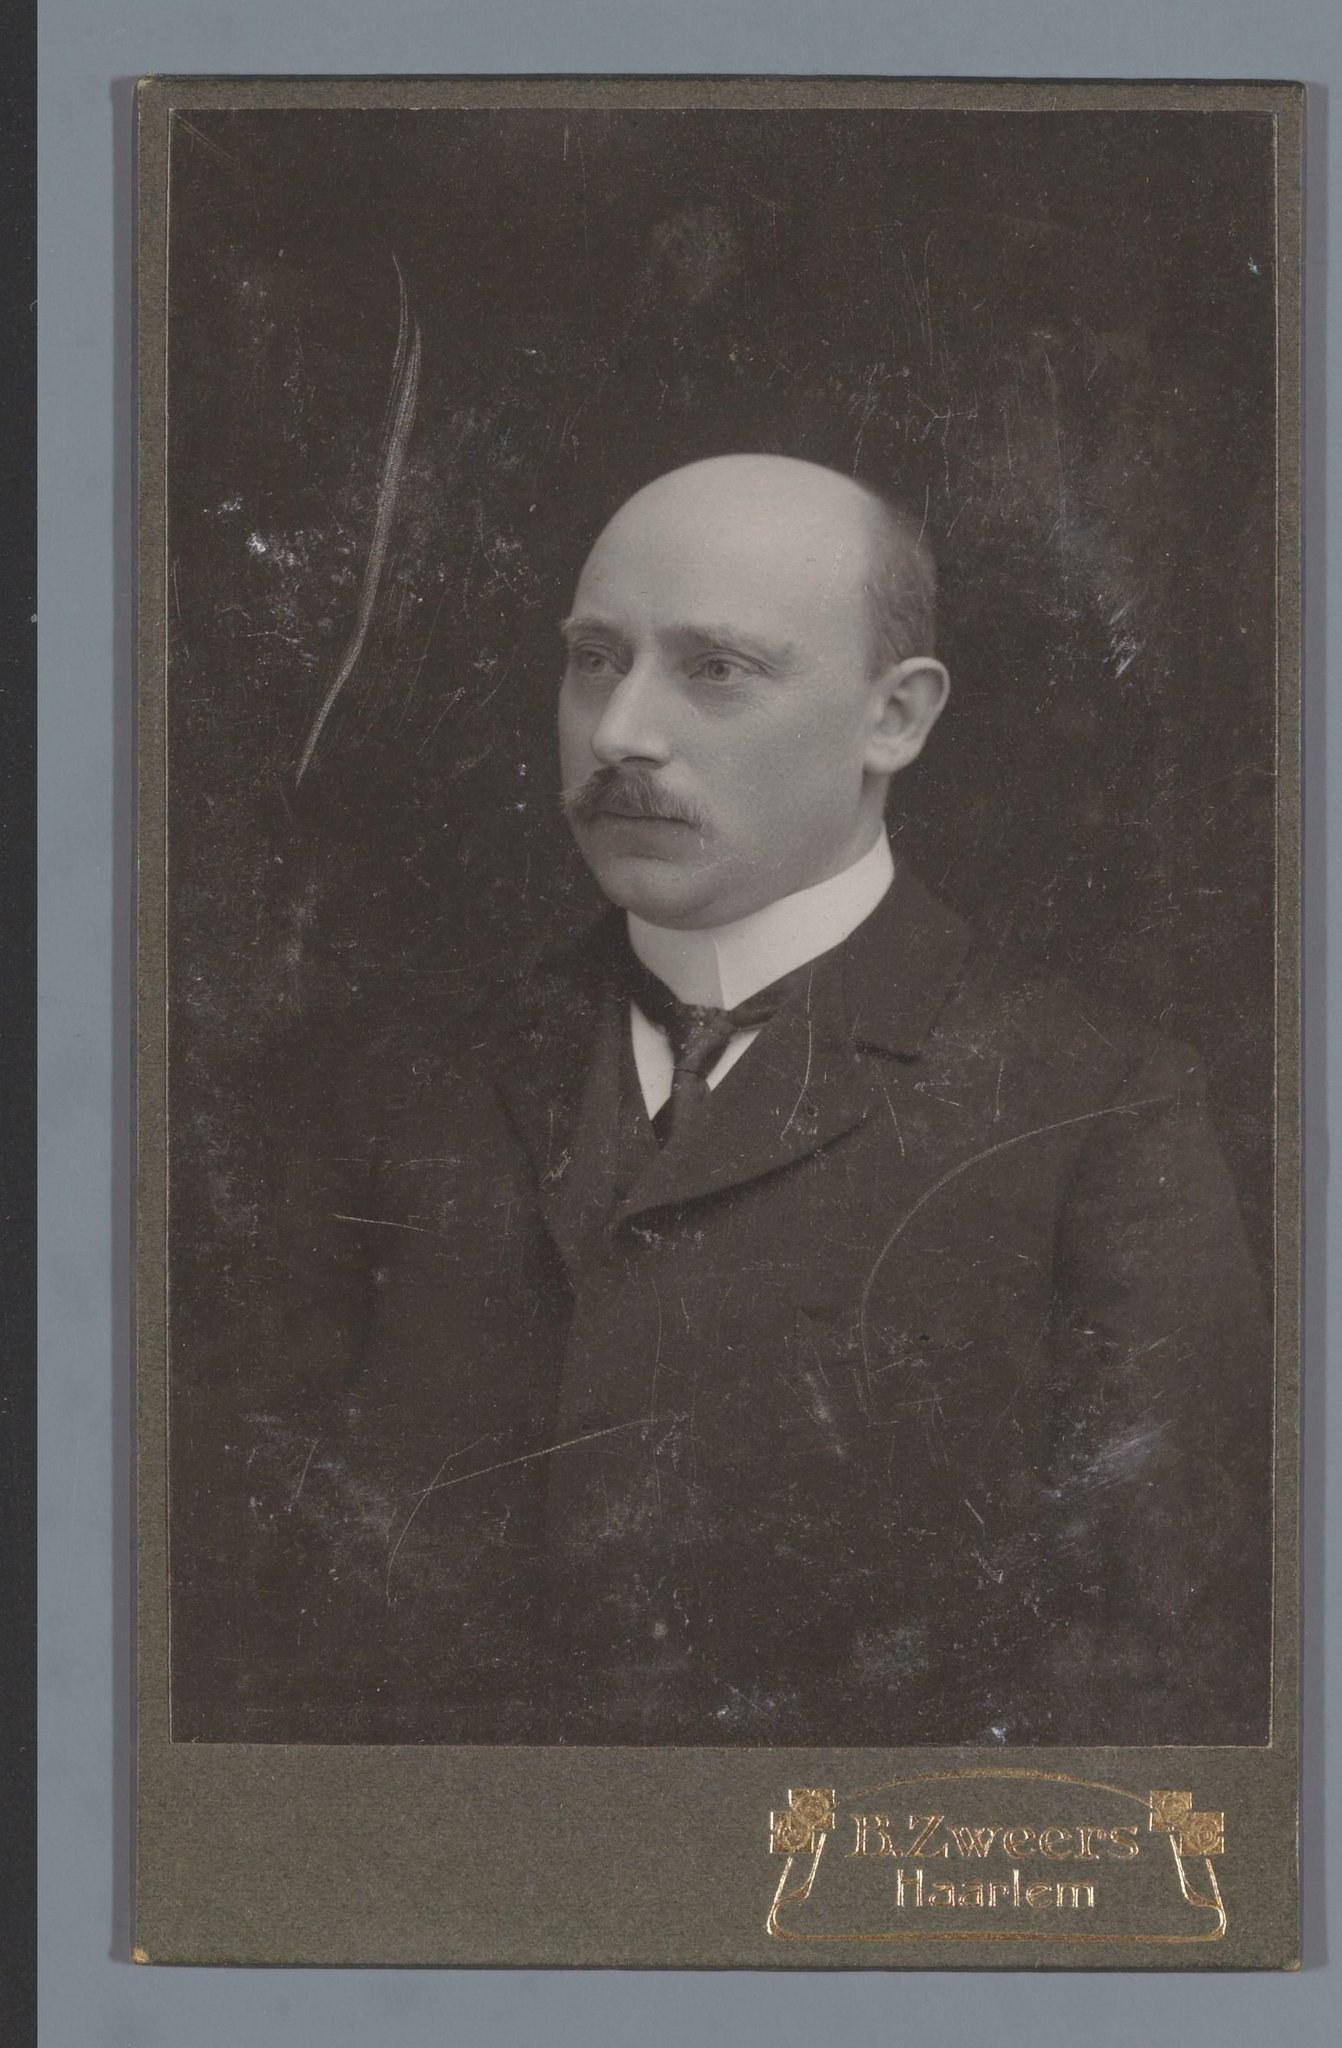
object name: photograph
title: Portret van een onbekende man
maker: berend zweers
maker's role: fotograaf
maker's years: 1872-1946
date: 1807-1920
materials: cardboard, paper, photographic support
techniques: gelatin silver print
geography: haarlem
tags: adult man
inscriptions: inscription: ‘B. Zweers 174 Groote Houtstraat 174 Haarlem Onderscheidingen Amsterdam 1895 's Gravenhage 1906 Turijn 1902 Leeuwarden 1906 Leiden 1907’, name: ‘B. Zweers Haarlem’